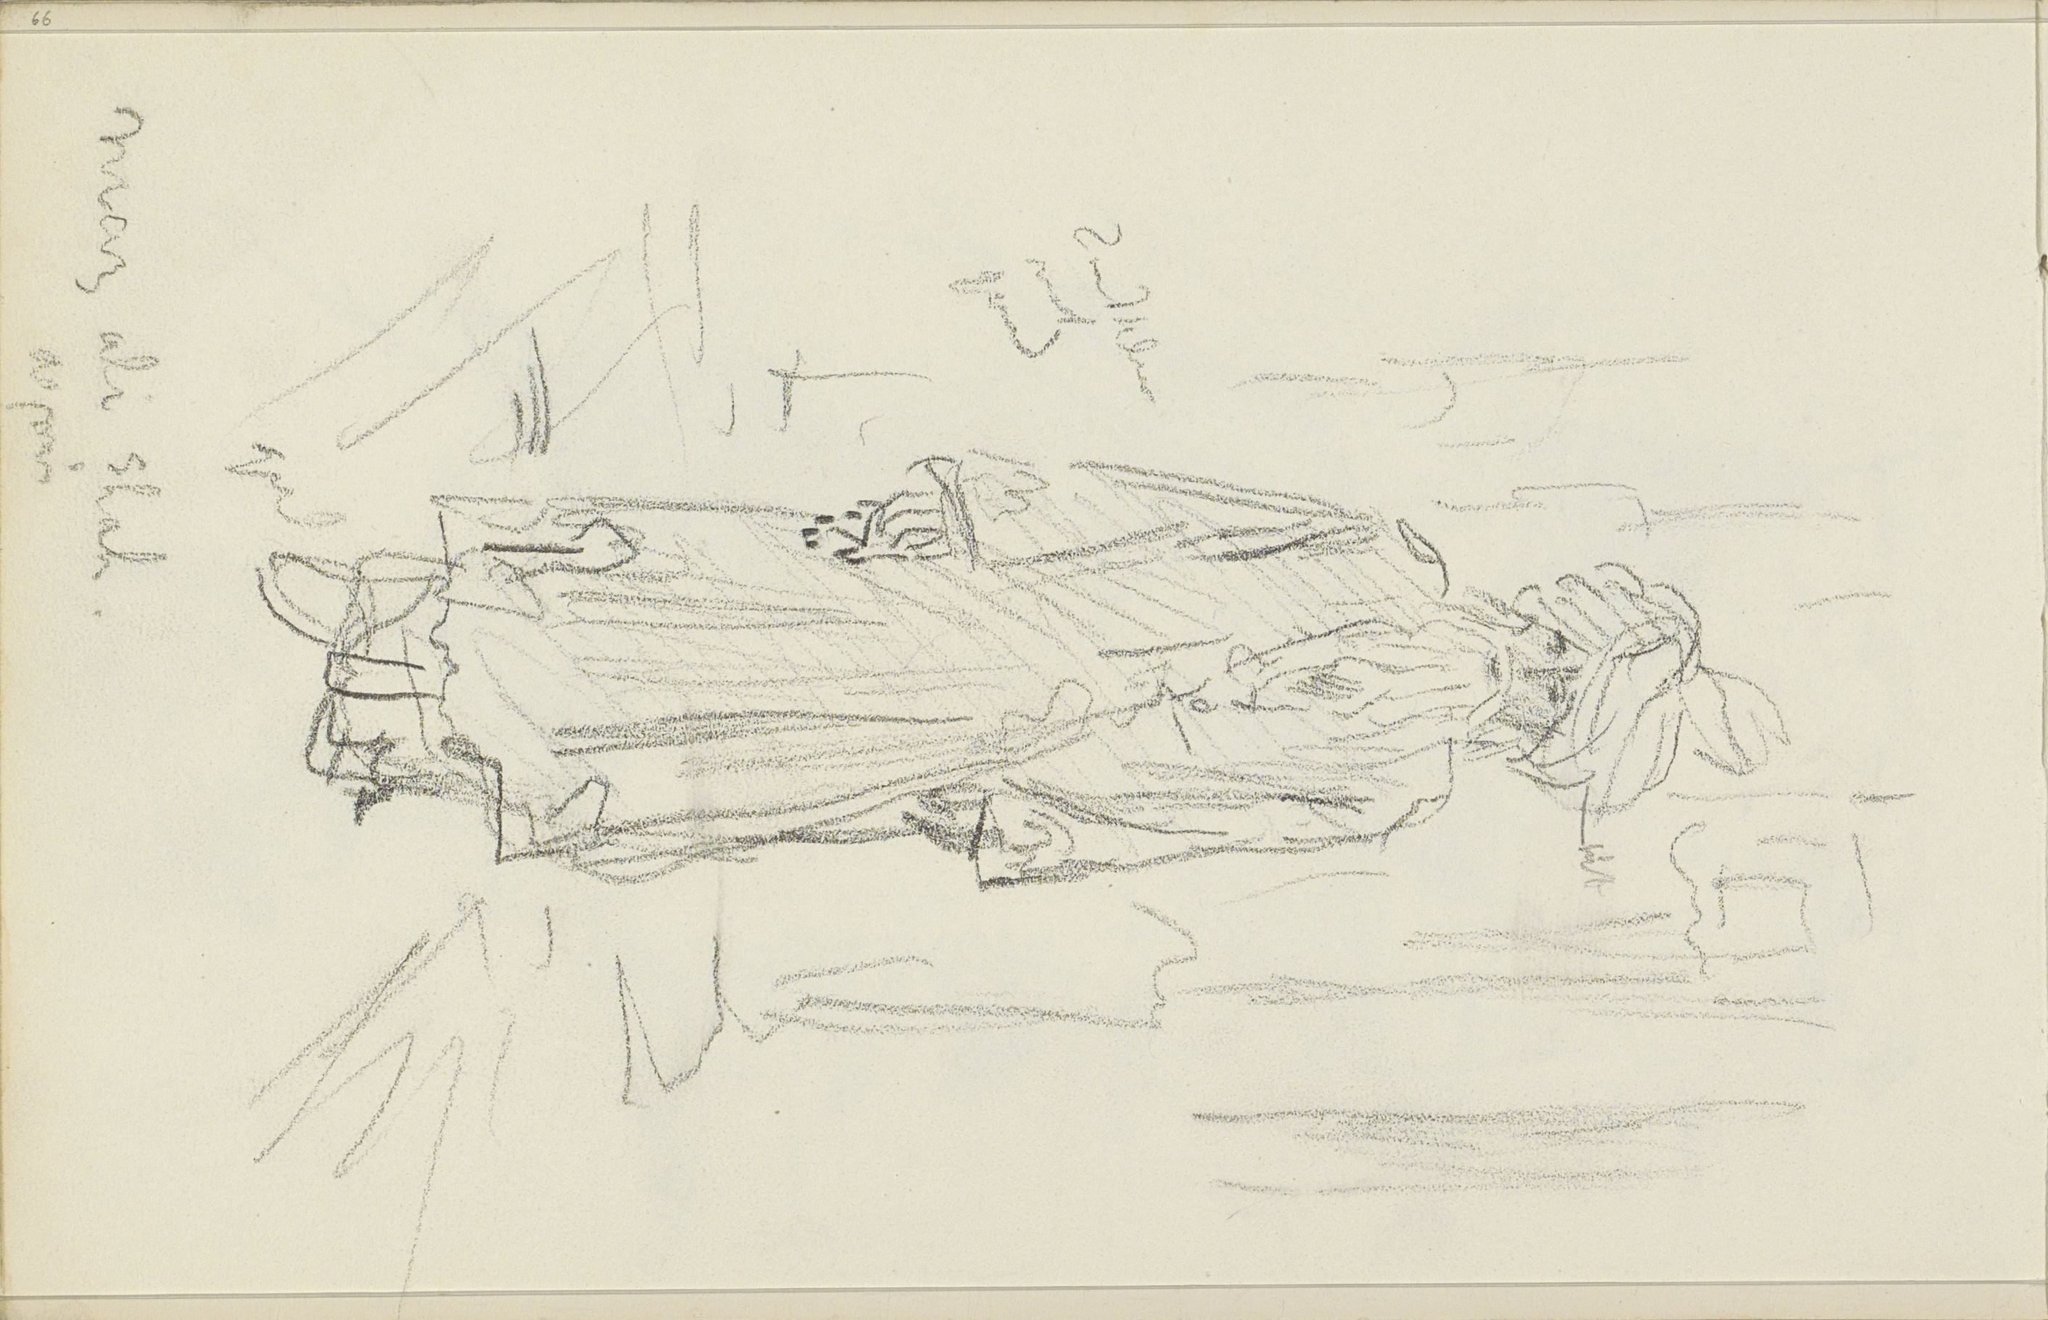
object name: sketchbook leaf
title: Indiër met een tulband, van voren gezien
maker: marius bauer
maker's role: draughtsman, print maker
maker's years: 1867-1932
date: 1924-1925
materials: paper, pencil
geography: india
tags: standing figure, adult man, head-gear: turban, asiatic races and peoples: indians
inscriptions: annotation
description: Pagina 66 uit een schetsboek met 48 bladen.